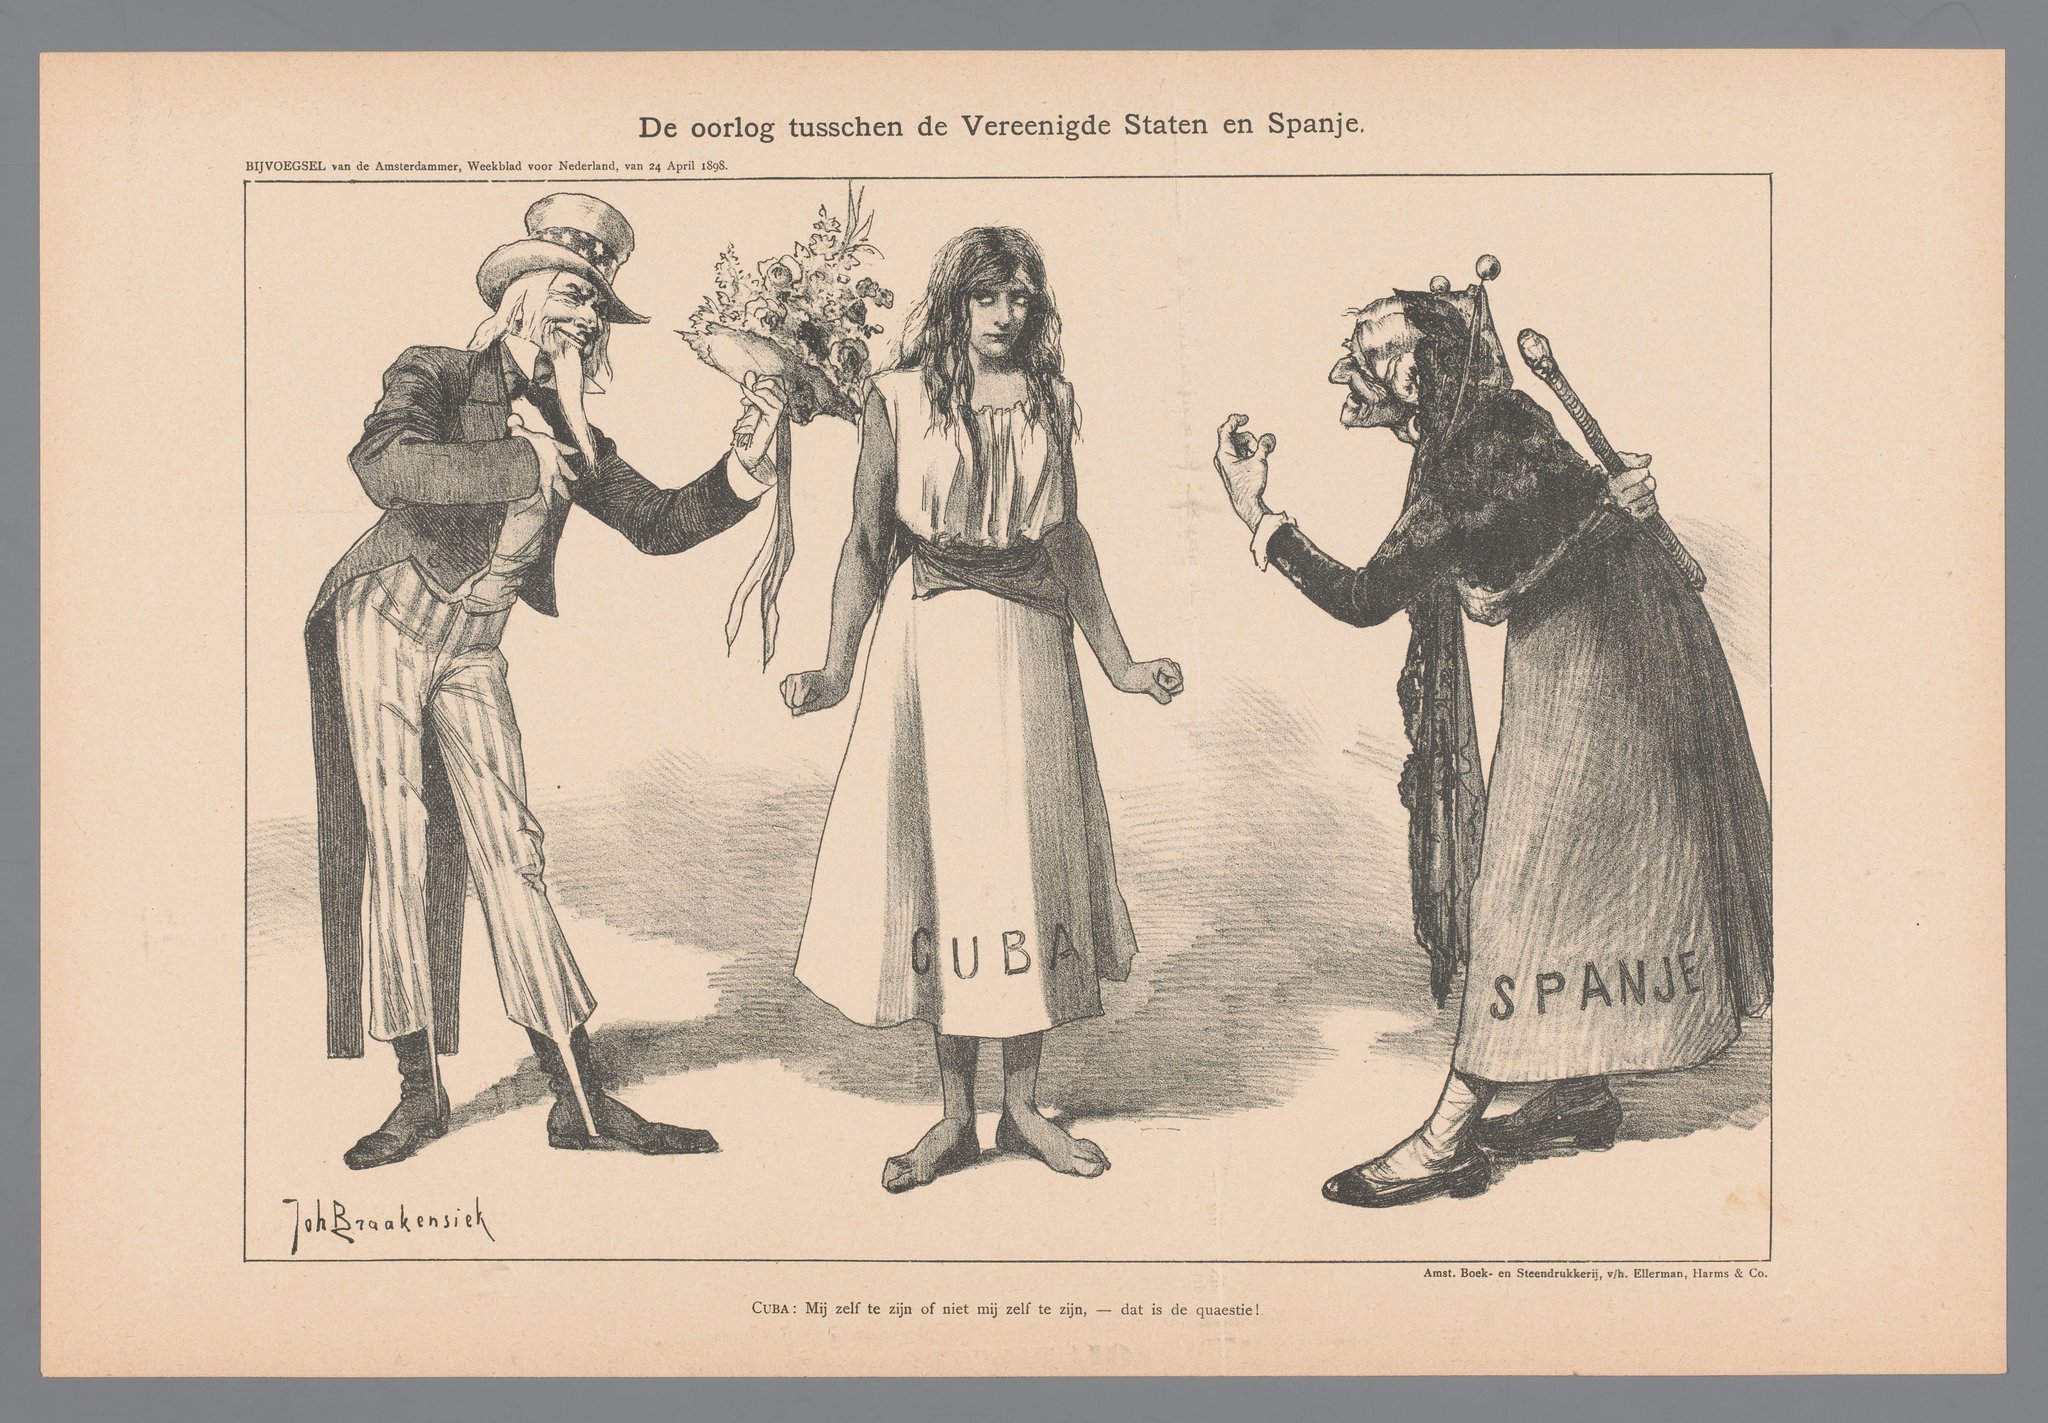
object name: cartoon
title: De oorlog tusschen de Vereenigde Staten en Spanje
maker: johan braakensiek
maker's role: draughtsman, print maker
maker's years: 1858-1940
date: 1898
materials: paper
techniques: lithograph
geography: amsterdam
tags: cut flowers; nosegay, bunch of flowers, personifications of countries, nations, states, districts, etc. (+ nation; national), bringing gifts; exchanging gifts, political caricatures and satires, united states of america, spain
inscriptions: date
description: Prent uit het bijvoegsel van: De Amsterdammer. Weekblad voor Nederland, 28 april 1898.